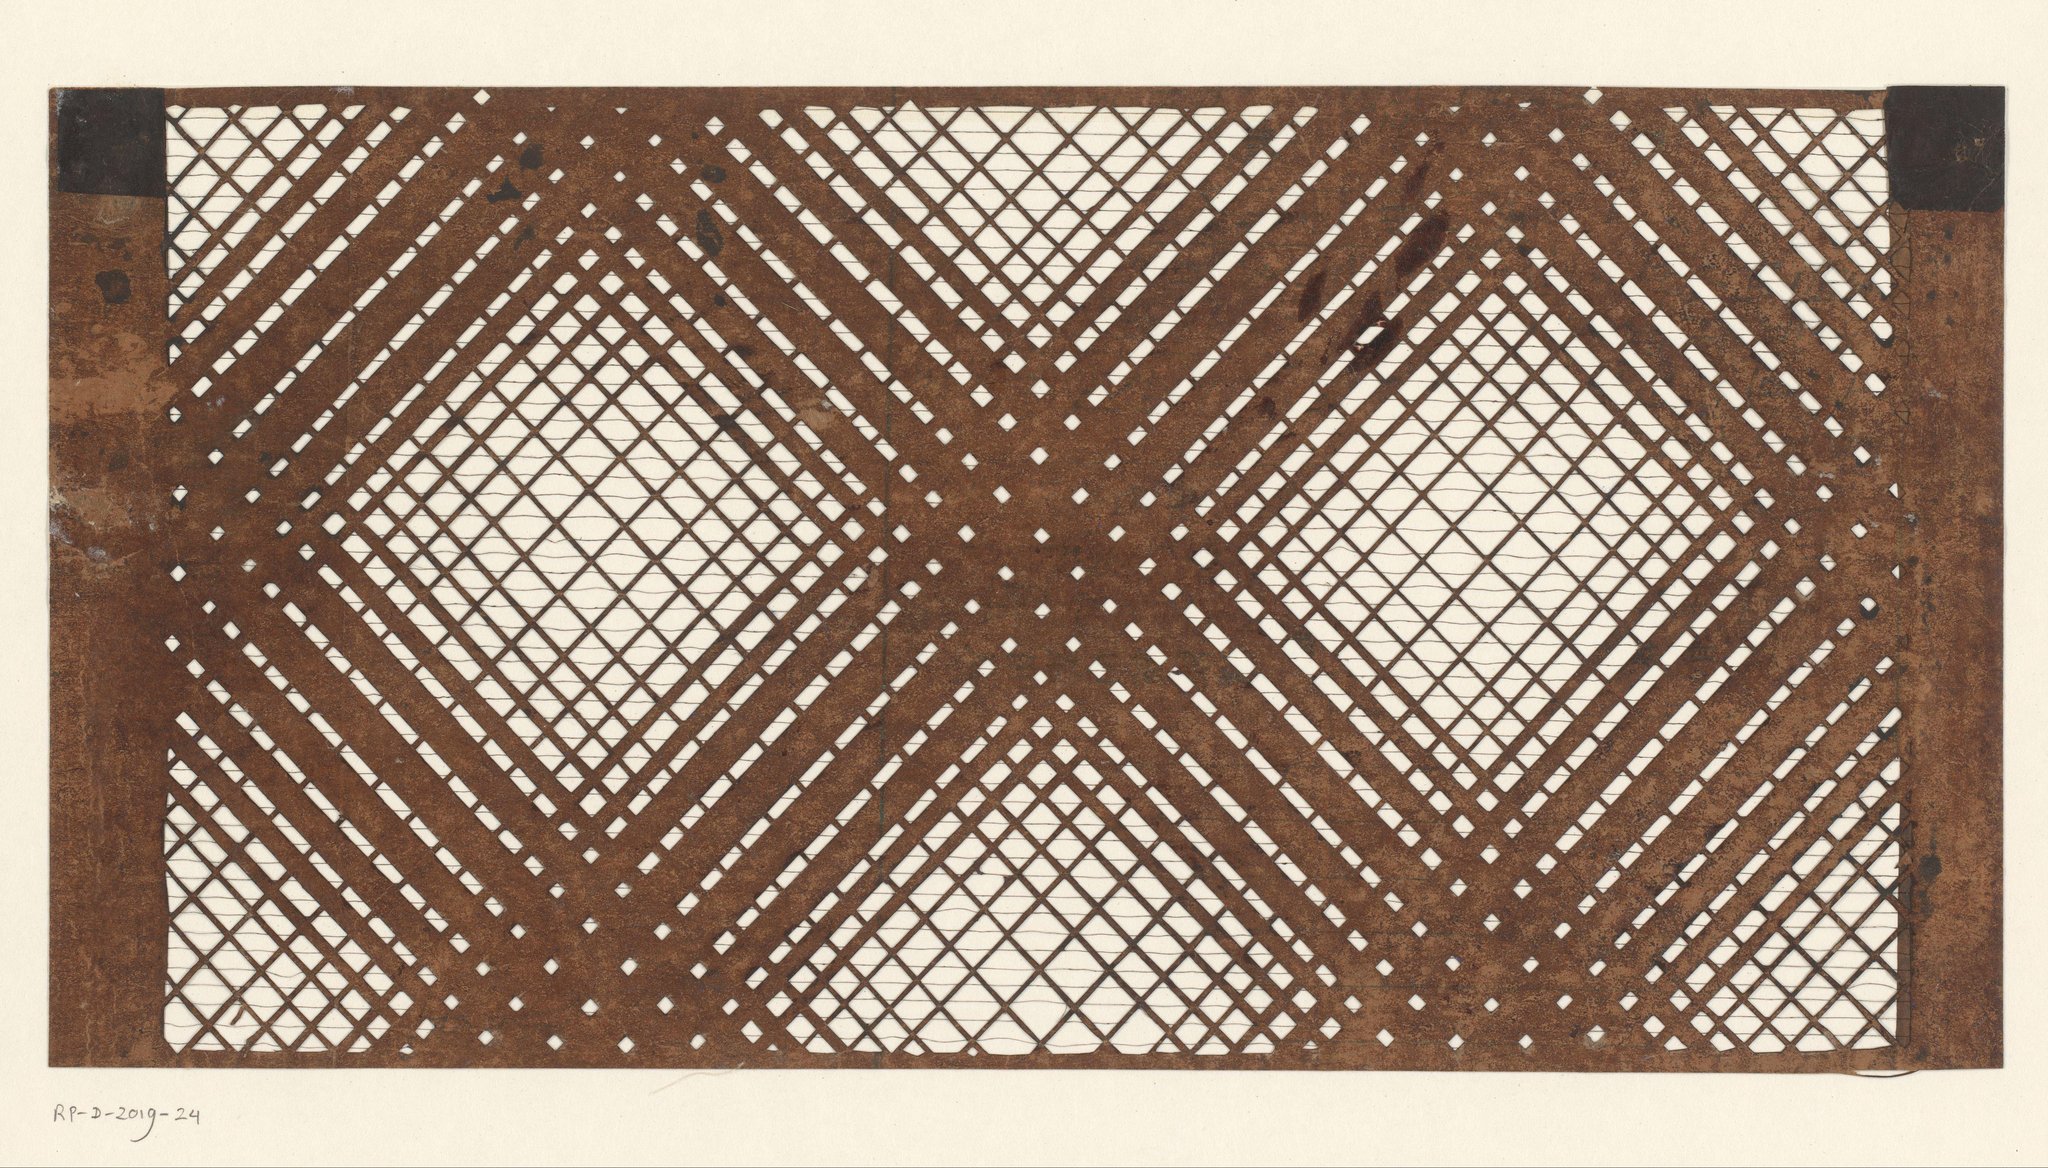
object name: katagami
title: Sjabloon met diagonaal patroon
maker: Anonymous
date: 1800-1909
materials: paper, silk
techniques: cutting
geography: japan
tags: ornament ~ straight lines (right angles only)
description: Japanse sjabloon (katagami) met een geometrisch patroon van diagonale lijnen.